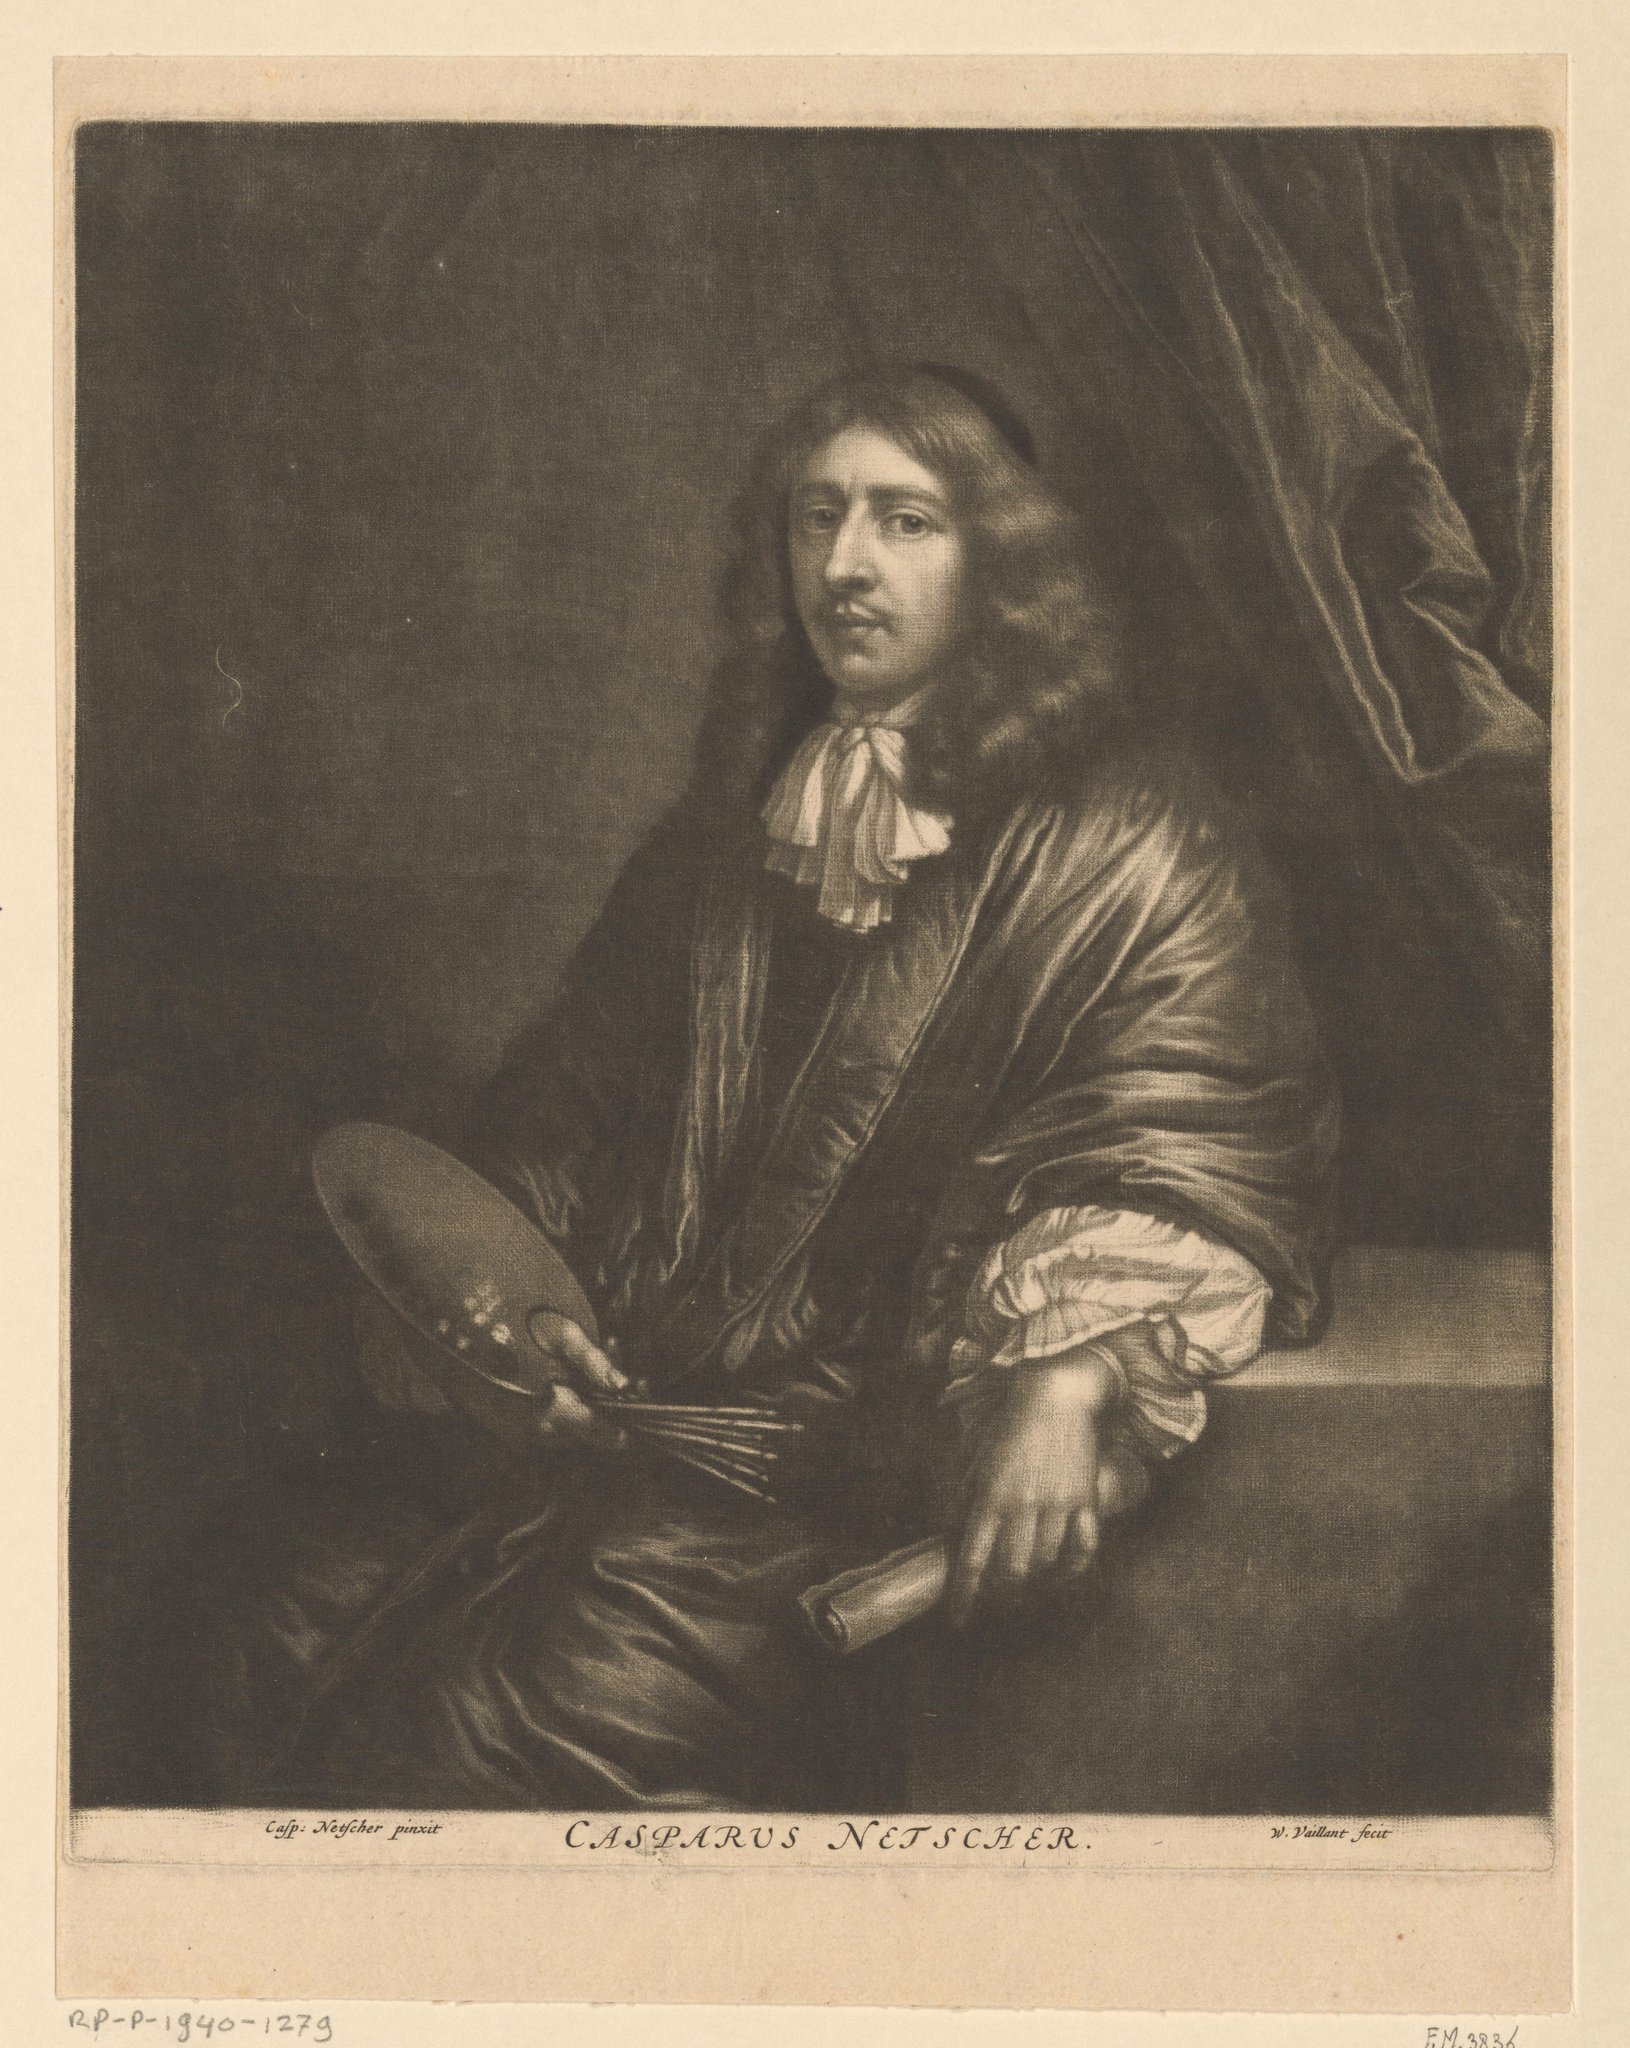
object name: print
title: Portret van Caspar Netscher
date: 1649-1677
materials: paper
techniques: mezzotint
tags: the hague, painter, print maker, draughtsman, caspar netscher, historical persons, portrait, self-portrait of painter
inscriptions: collector's mark: Lugt 2760, collector's mark: Lugt 2228